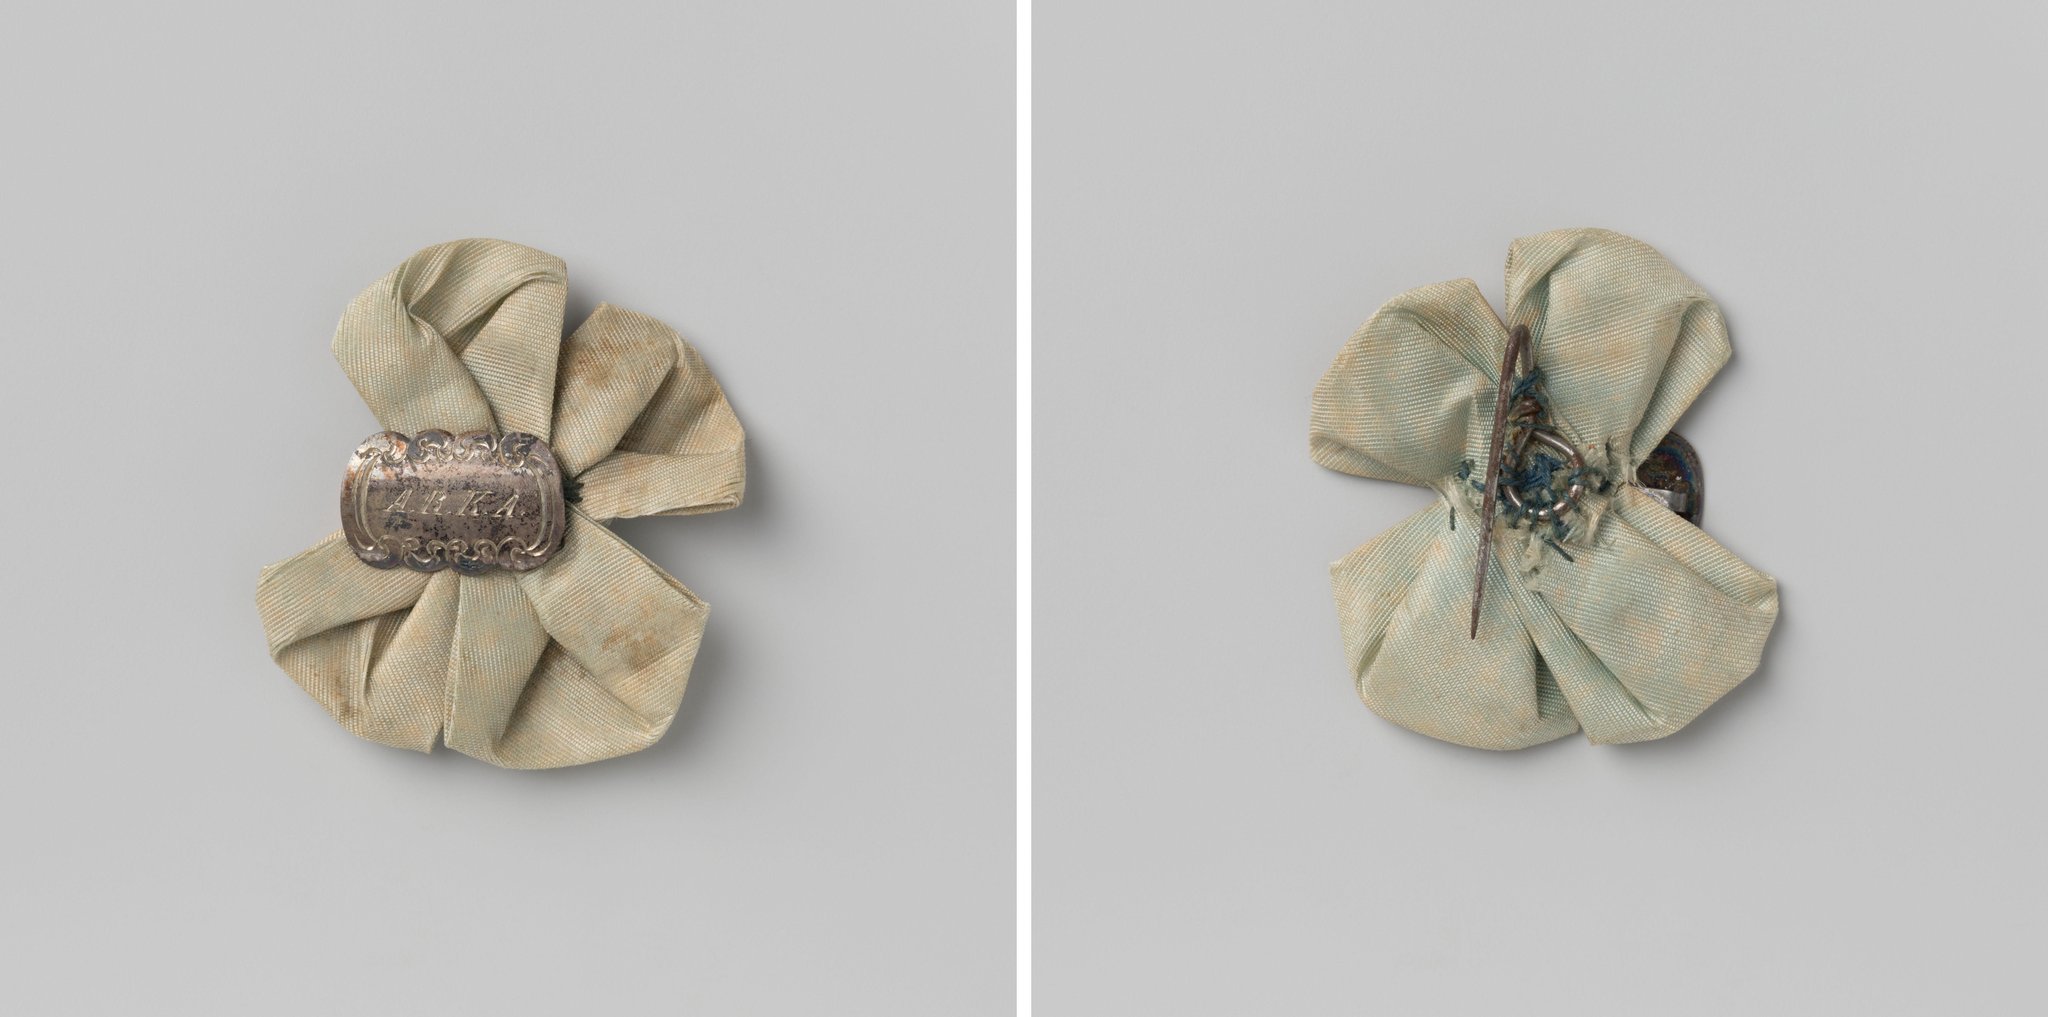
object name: insignia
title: Vereniging A.R.K.A.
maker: Anonymous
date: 1825-1875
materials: silver, textile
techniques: engraving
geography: netherlands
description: eenzijdig insigne, bestaande uit langwerpig schild met aan onder- en bovenzijde vier lobben en met afgeronde zijden, gemonteerd op vaalgroene strik